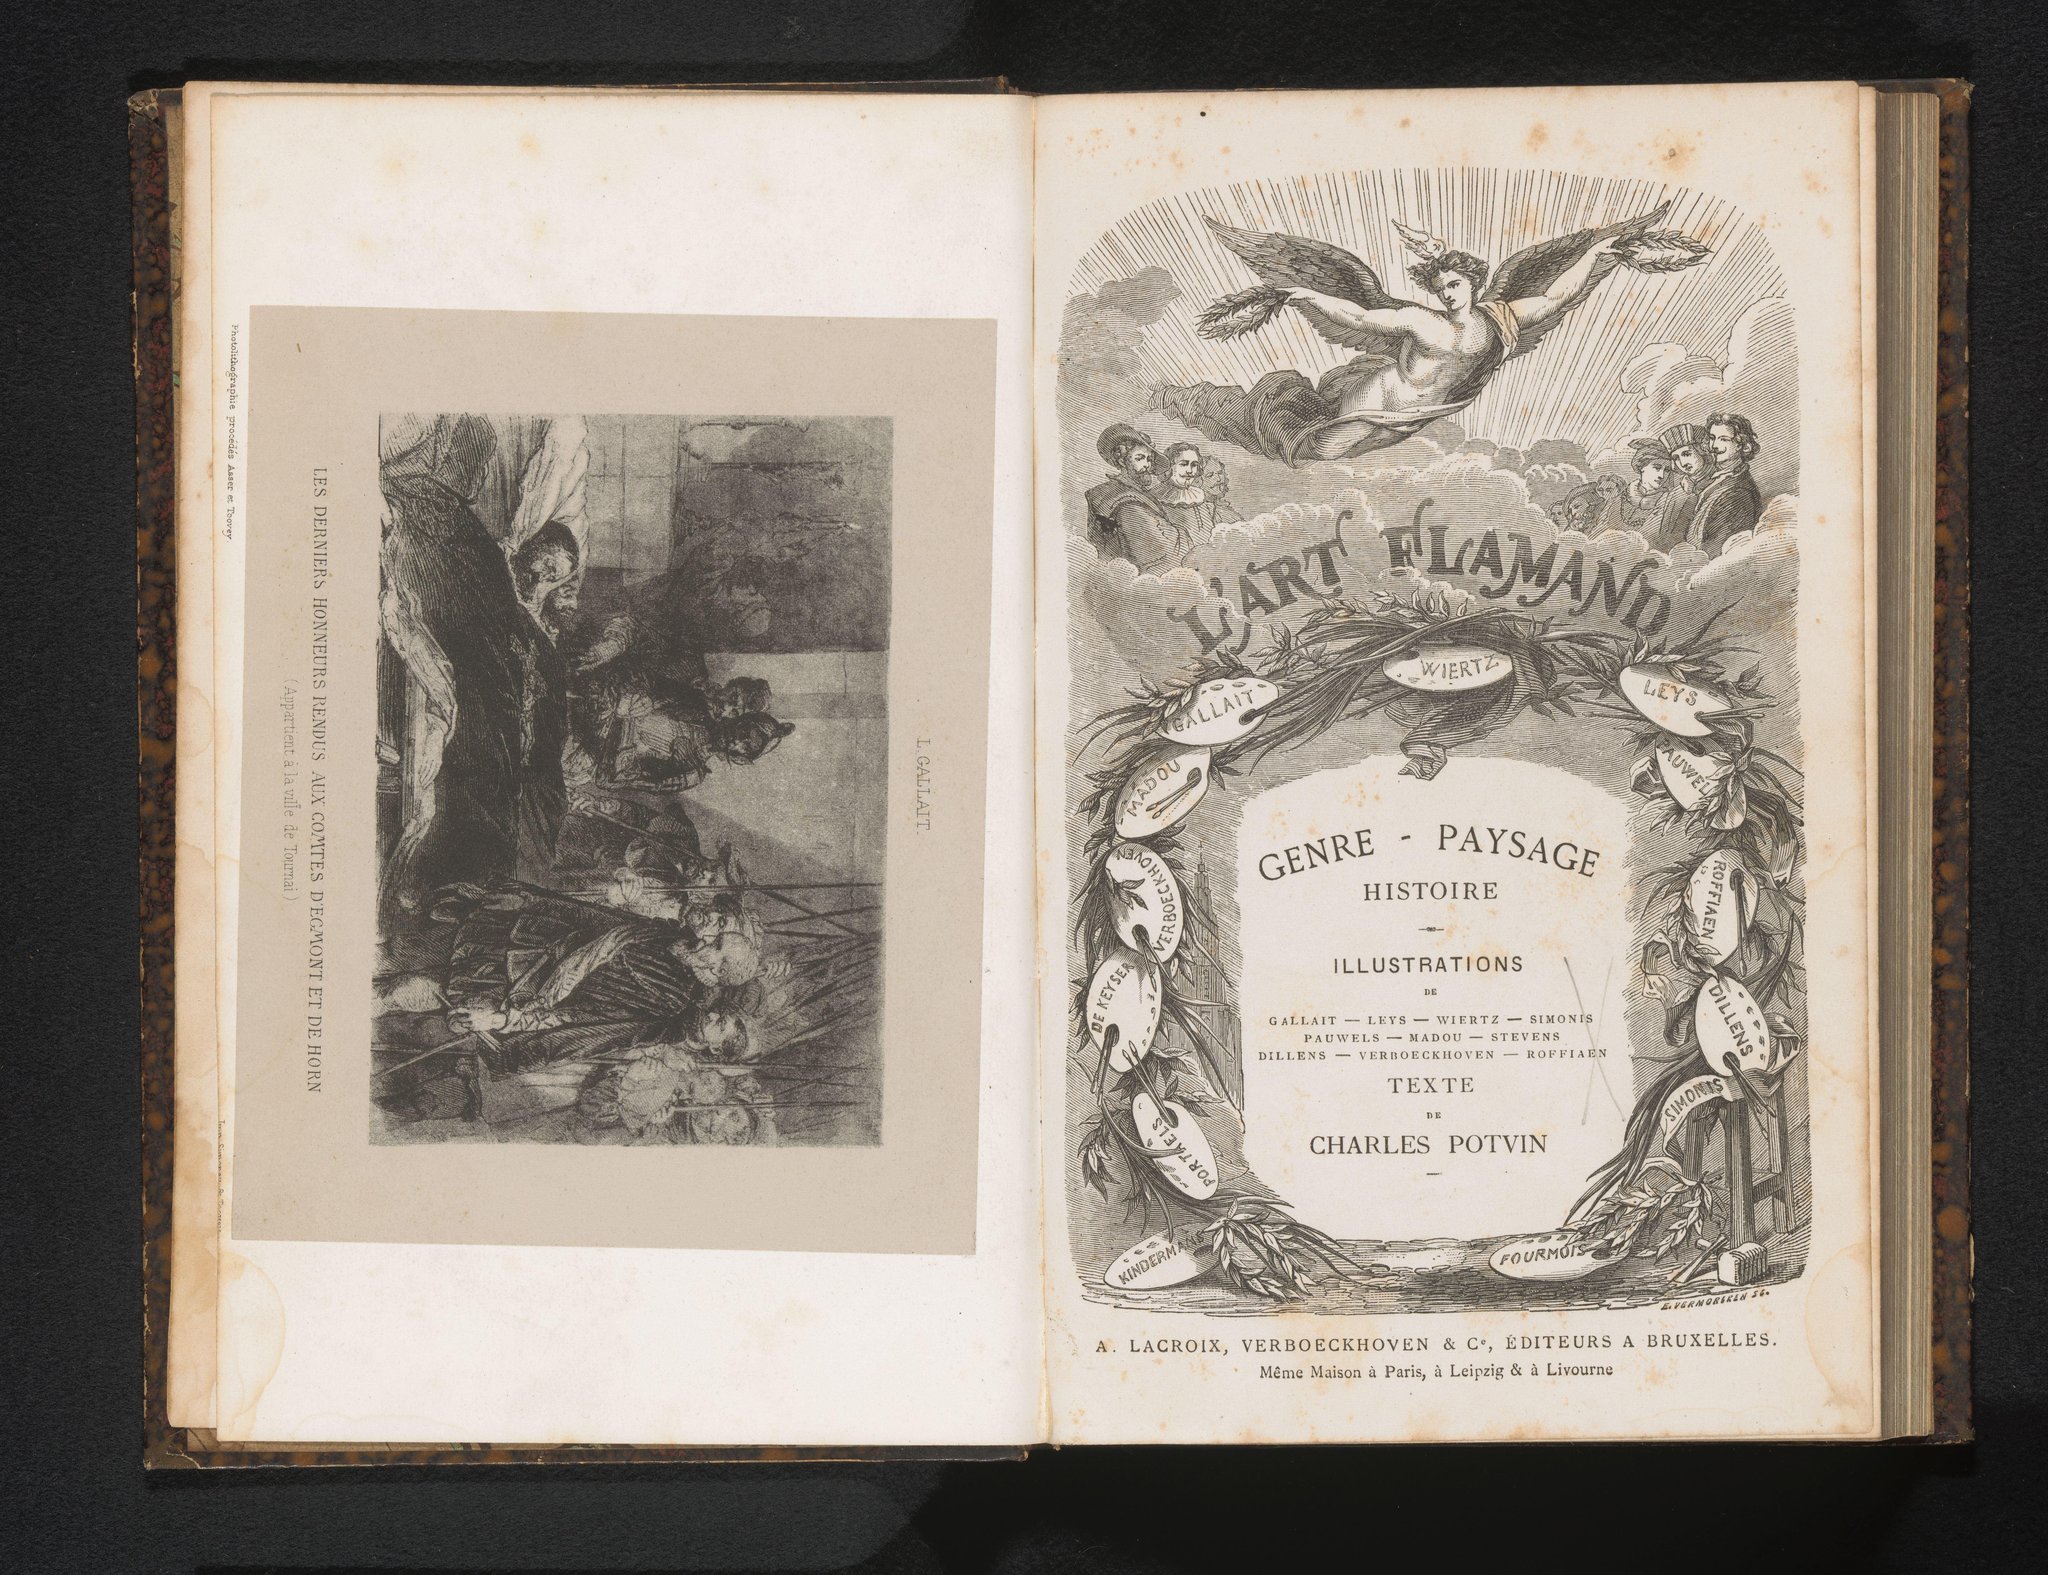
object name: reproduction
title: Reproductie van Laatste eerbetoon aan de graven van Egmont en Hornes door Louis Gallait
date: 1862-1867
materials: paper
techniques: photolithography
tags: paying tribute to a ruler, historical persons